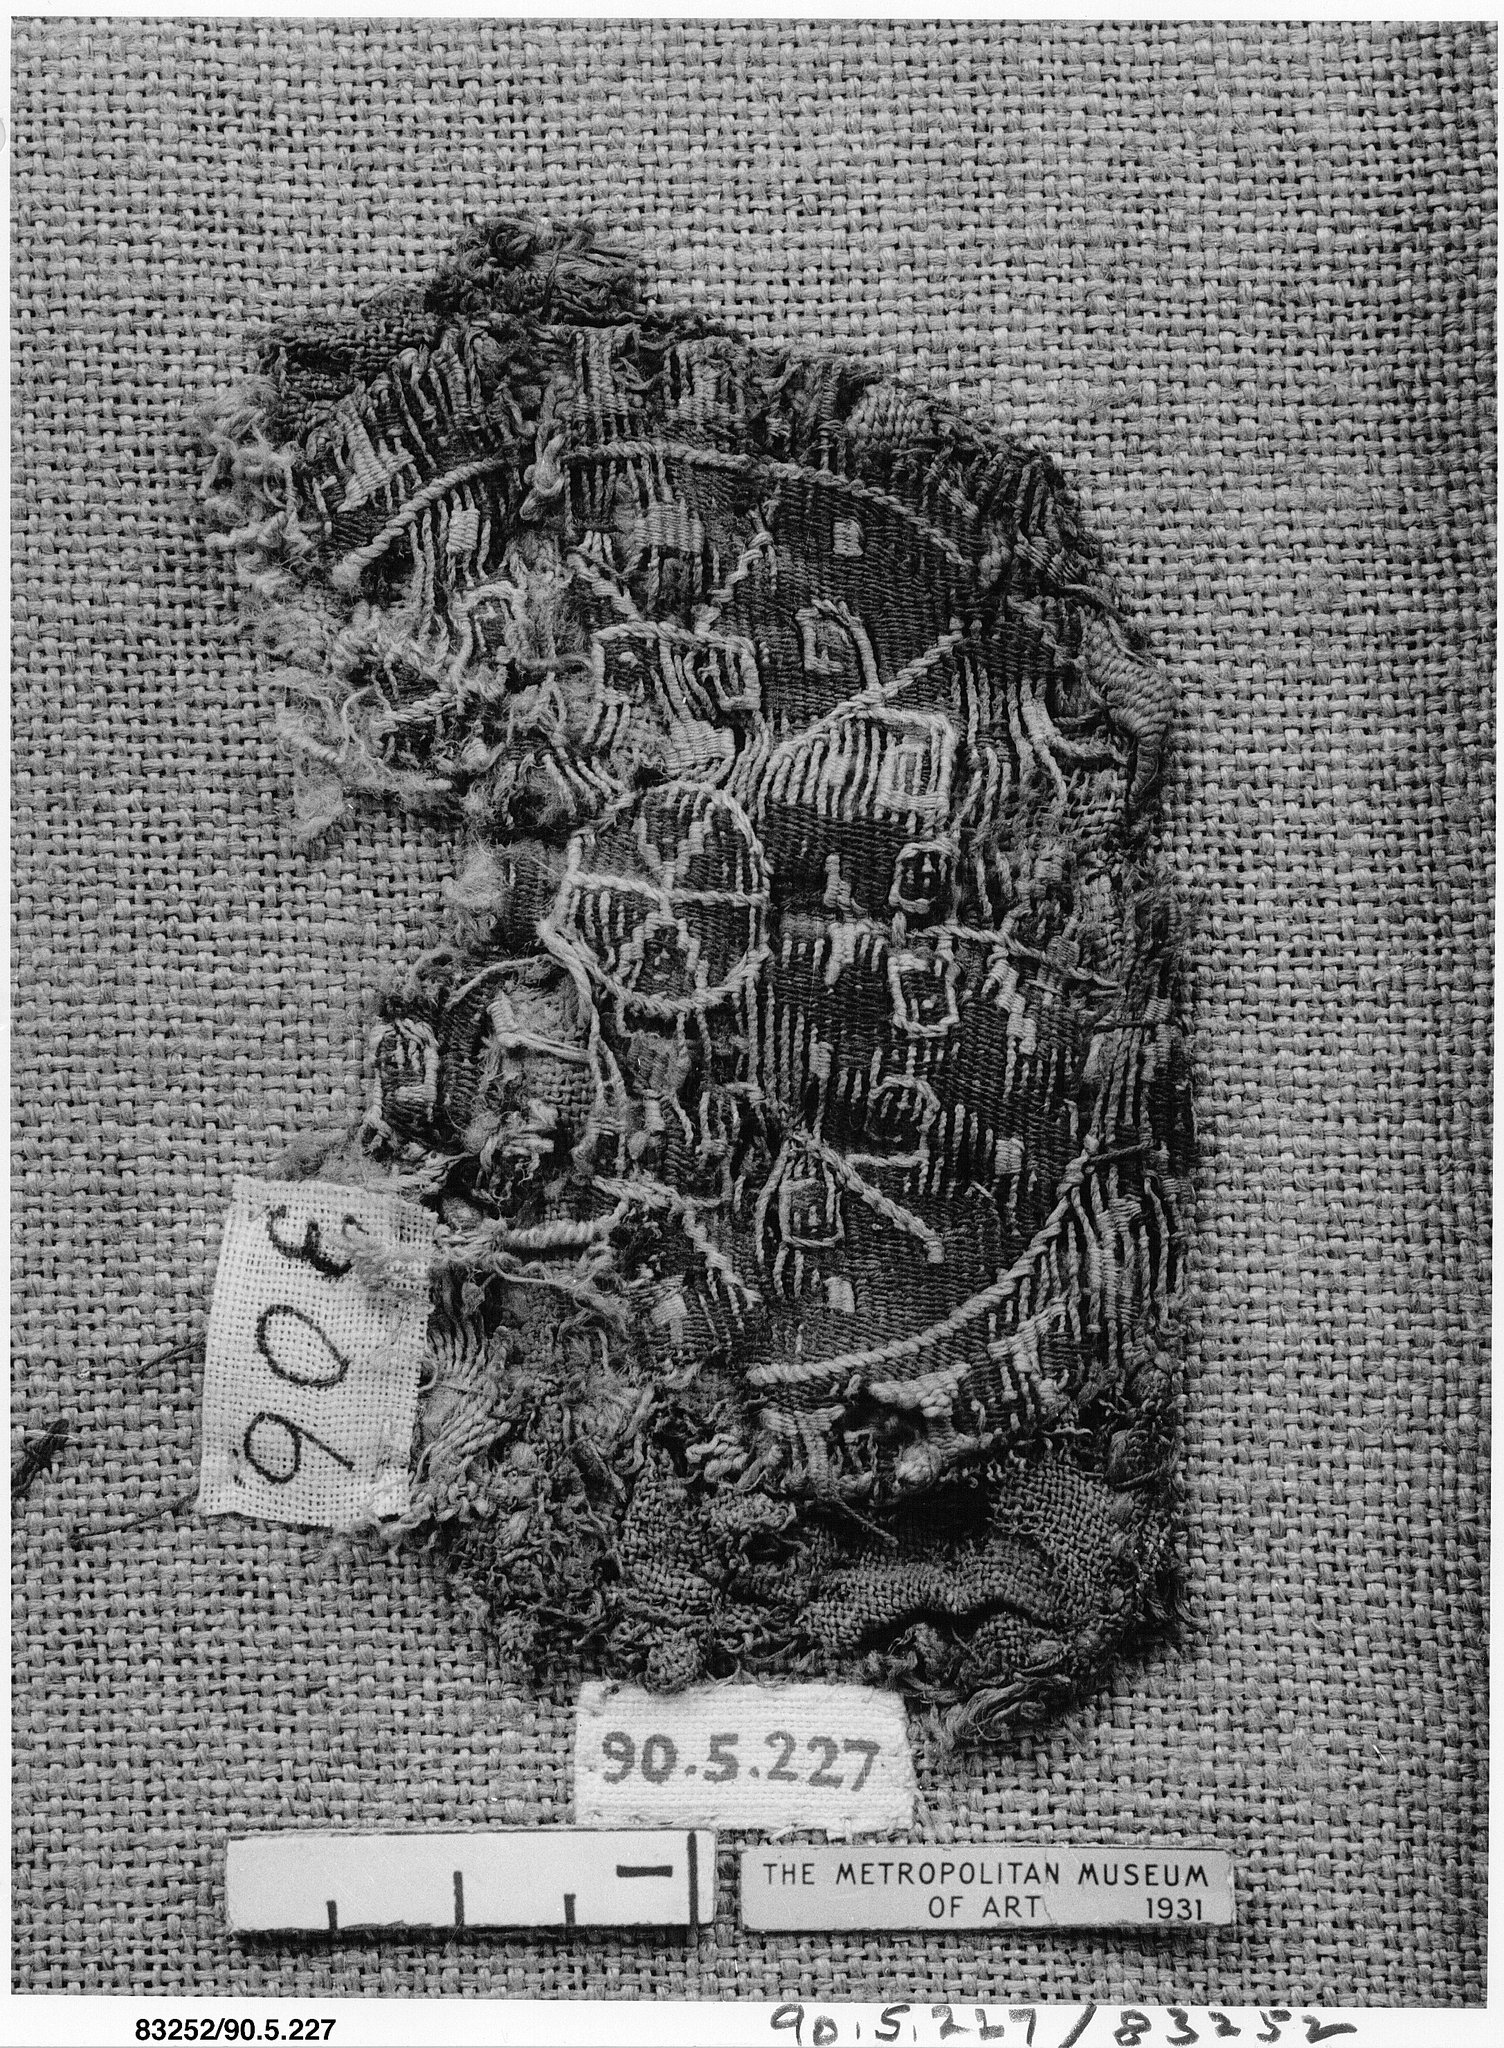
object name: textile fragment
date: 401-500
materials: linen, wool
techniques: weave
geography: egypt